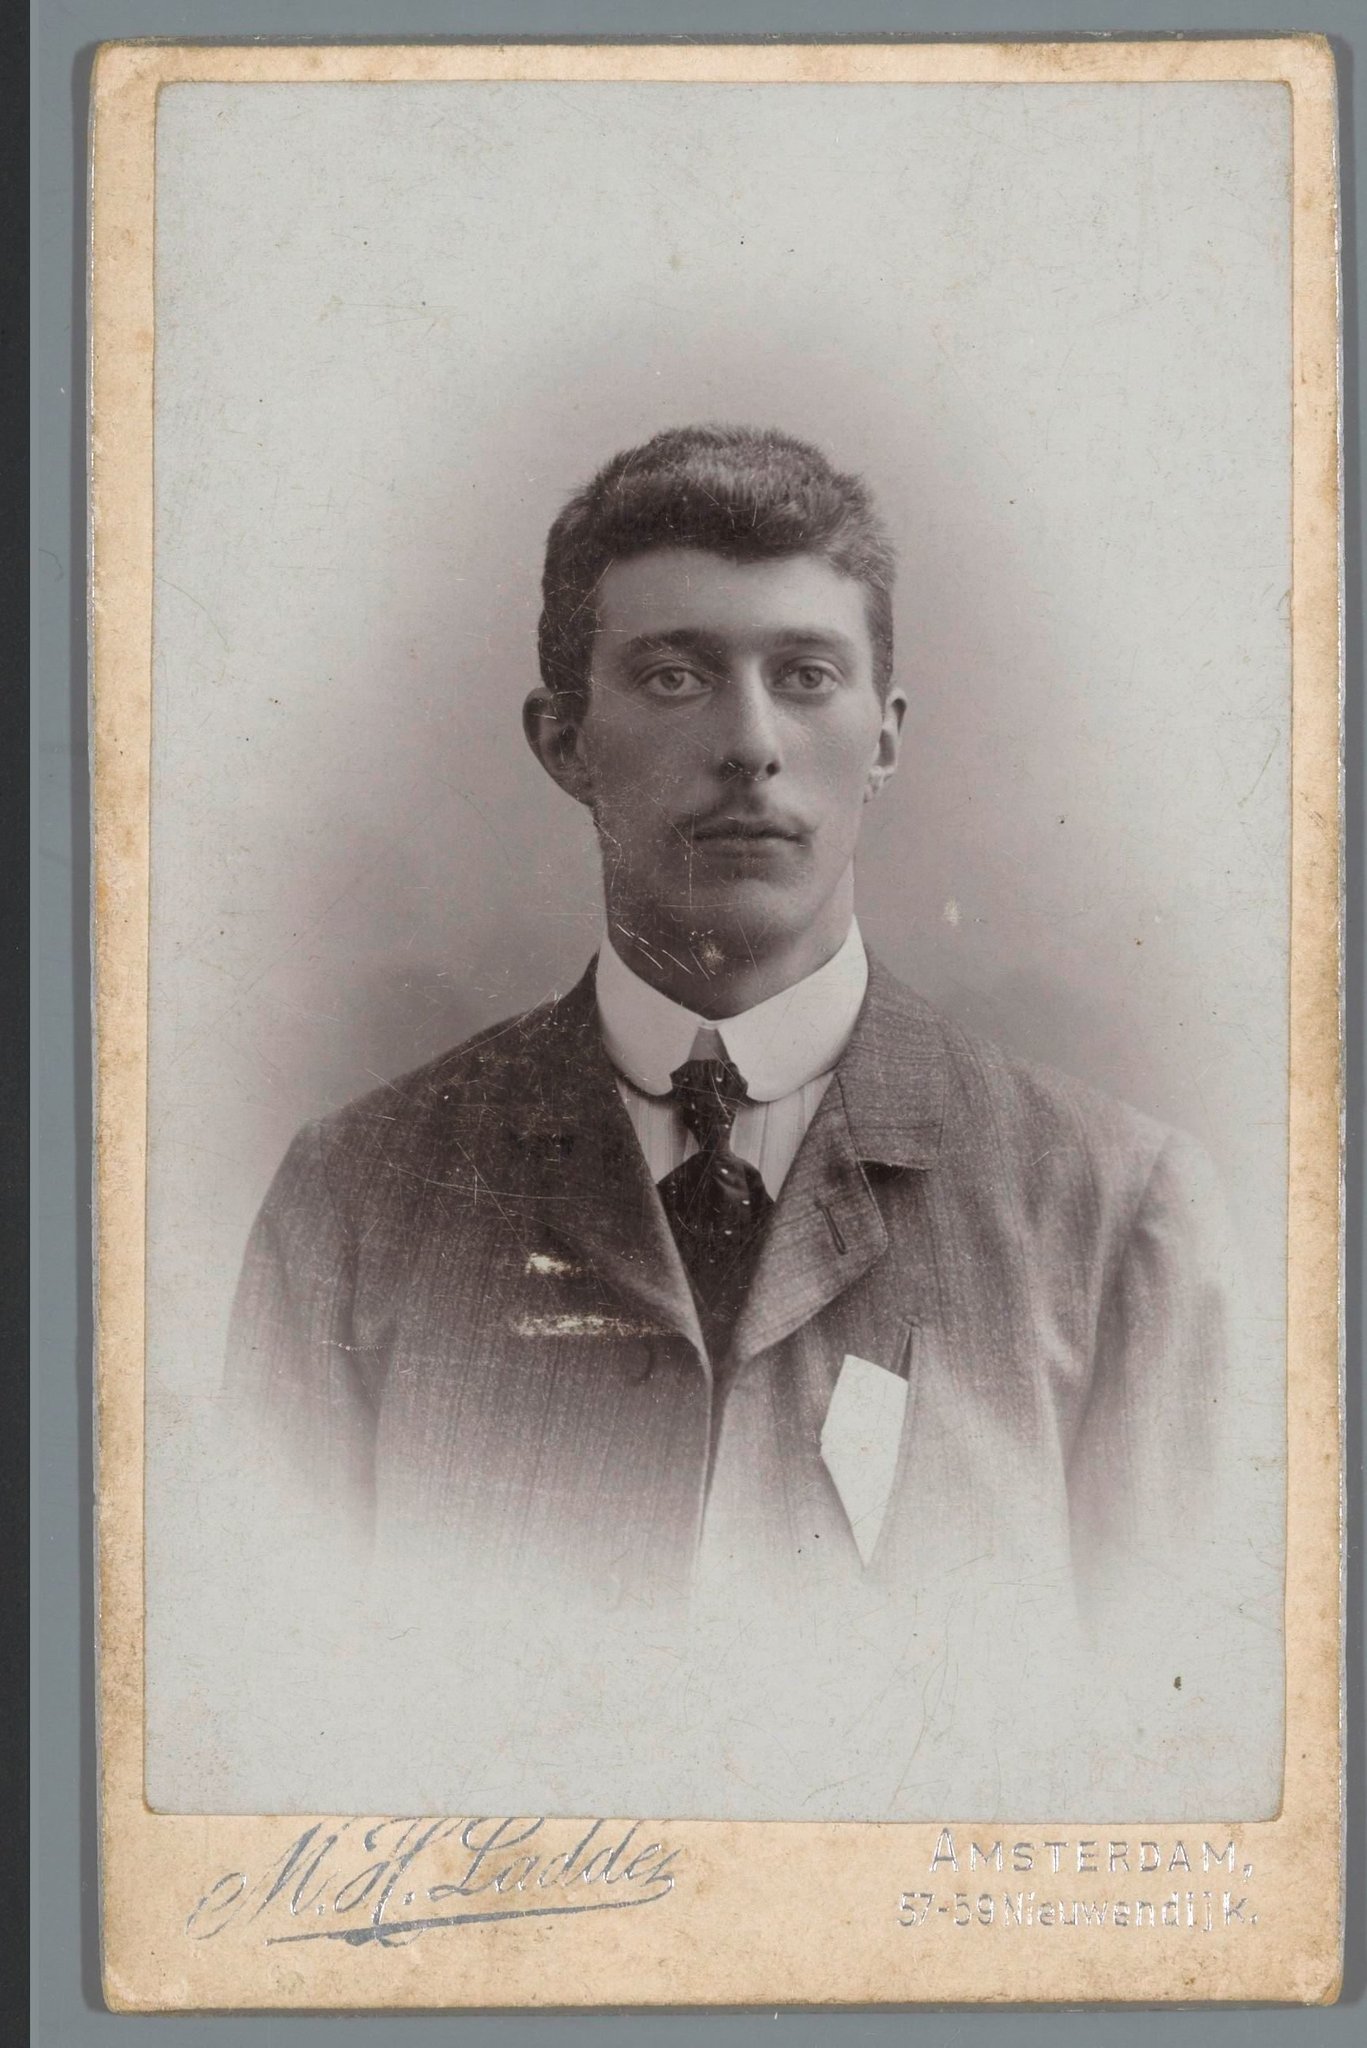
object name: carte de visite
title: Portret van een onbekende man, aangeduid als Hubert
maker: machiel hendricus laddé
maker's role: fotograaf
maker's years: 1866-1932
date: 1892-1906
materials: cardboard, photographic support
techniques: collodion silver print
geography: amsterdam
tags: adult man, historical persons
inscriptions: inscription: ‘Hubert.’, address: ‘M. H. Laddé/ AMSTERDAM./ 57-59 Nieuwendijk.’, number: ‘6/ 84261’